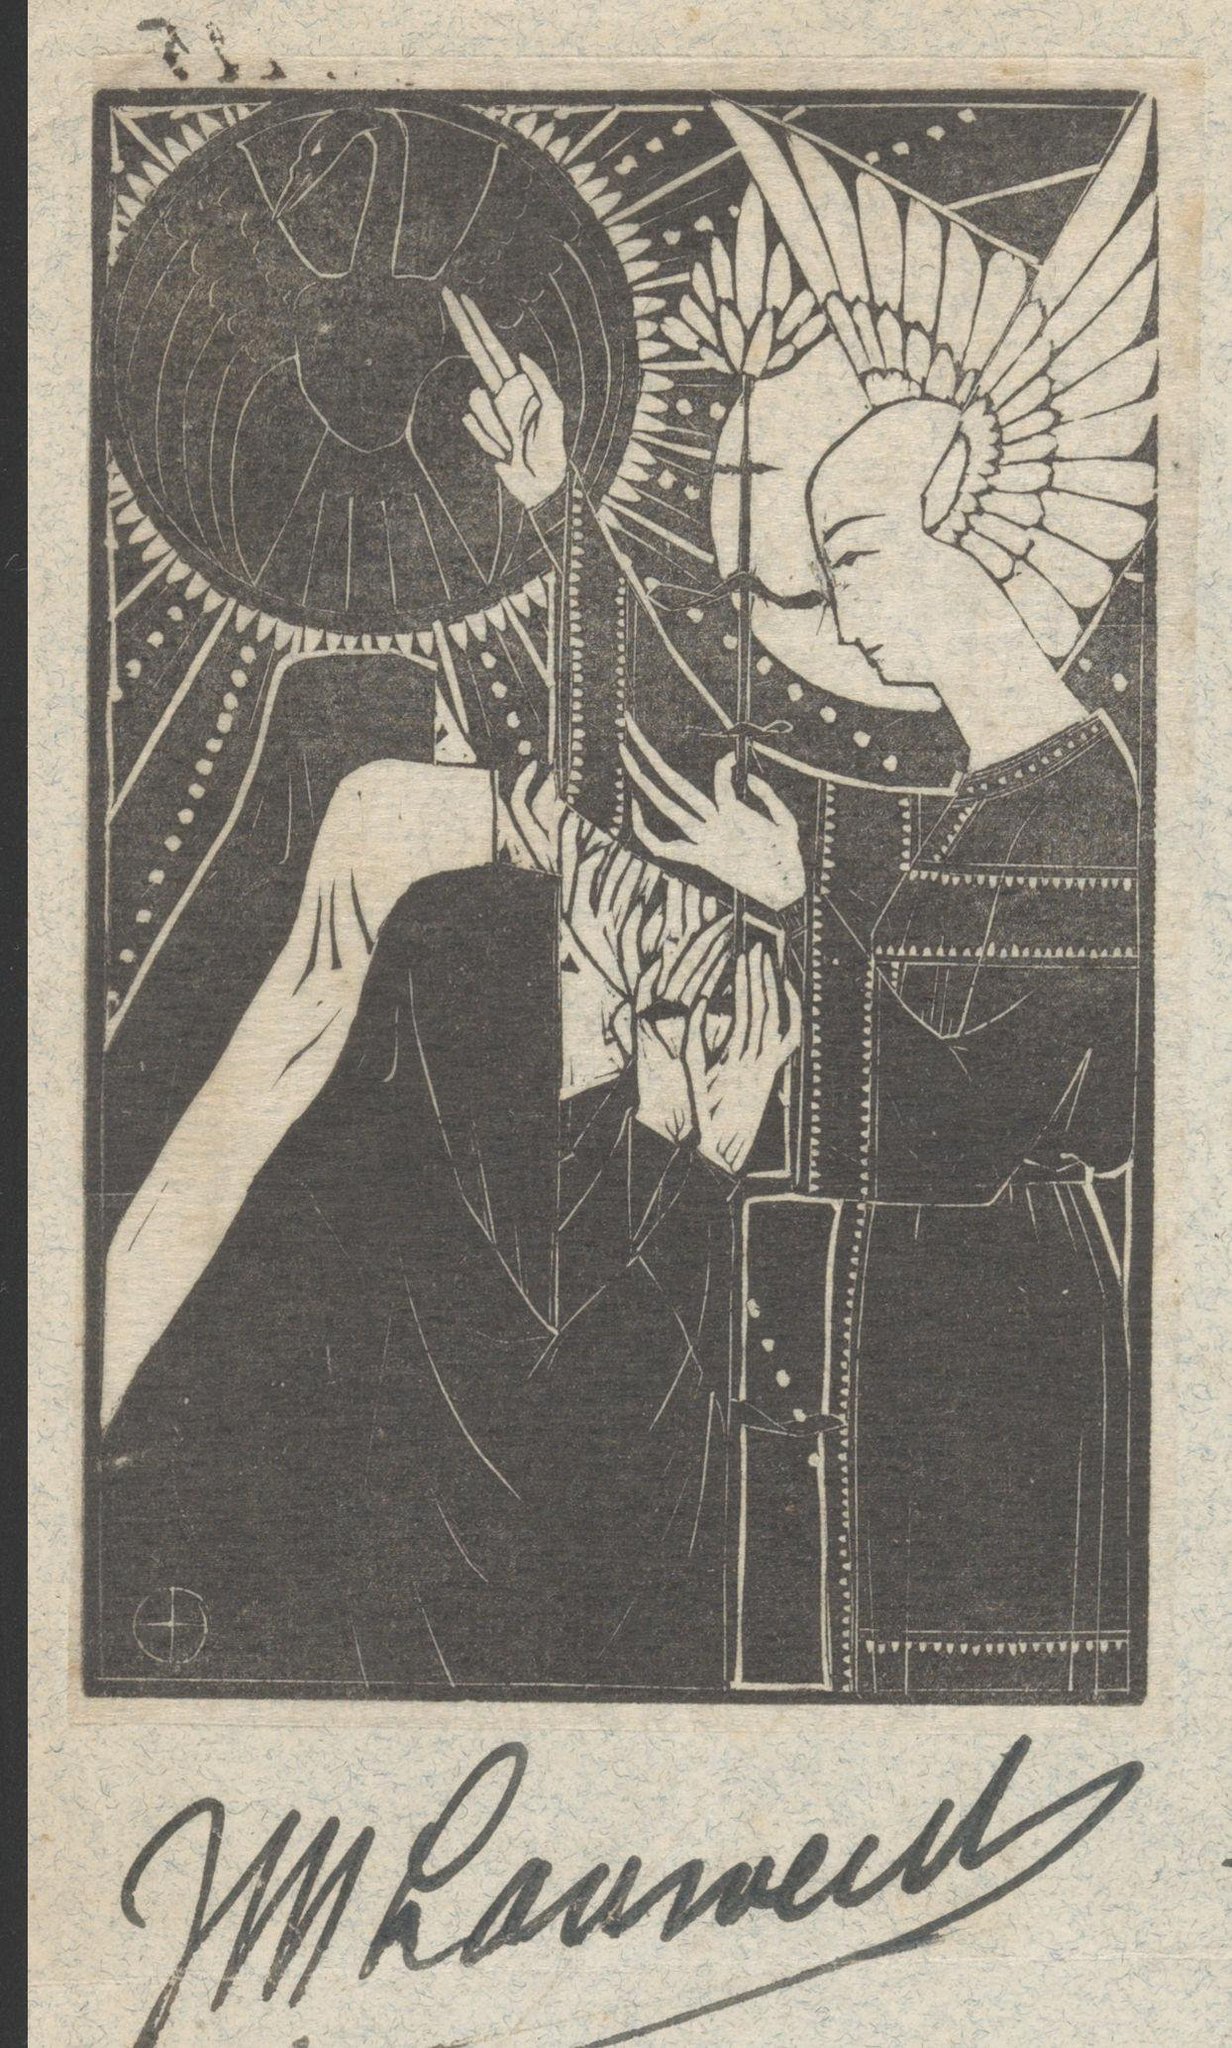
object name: print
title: Drie knielende figuren voor gevleugelde man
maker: mathieu lauweriks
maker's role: designer, draughtsman, print maker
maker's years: 1864-1932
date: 1895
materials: paper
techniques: woodcut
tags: kneeling figure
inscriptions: collector's mark: Lugt 2228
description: Rechts staat een man met vleugels in plaats van oren. Hij wendt zich tot de drie figuren die voor hem knielen. In zijn linkerhand houdt hij een bloem; met rechts wijst hij naar de zon waarin een vogel met gespreide vleugels te zien is.